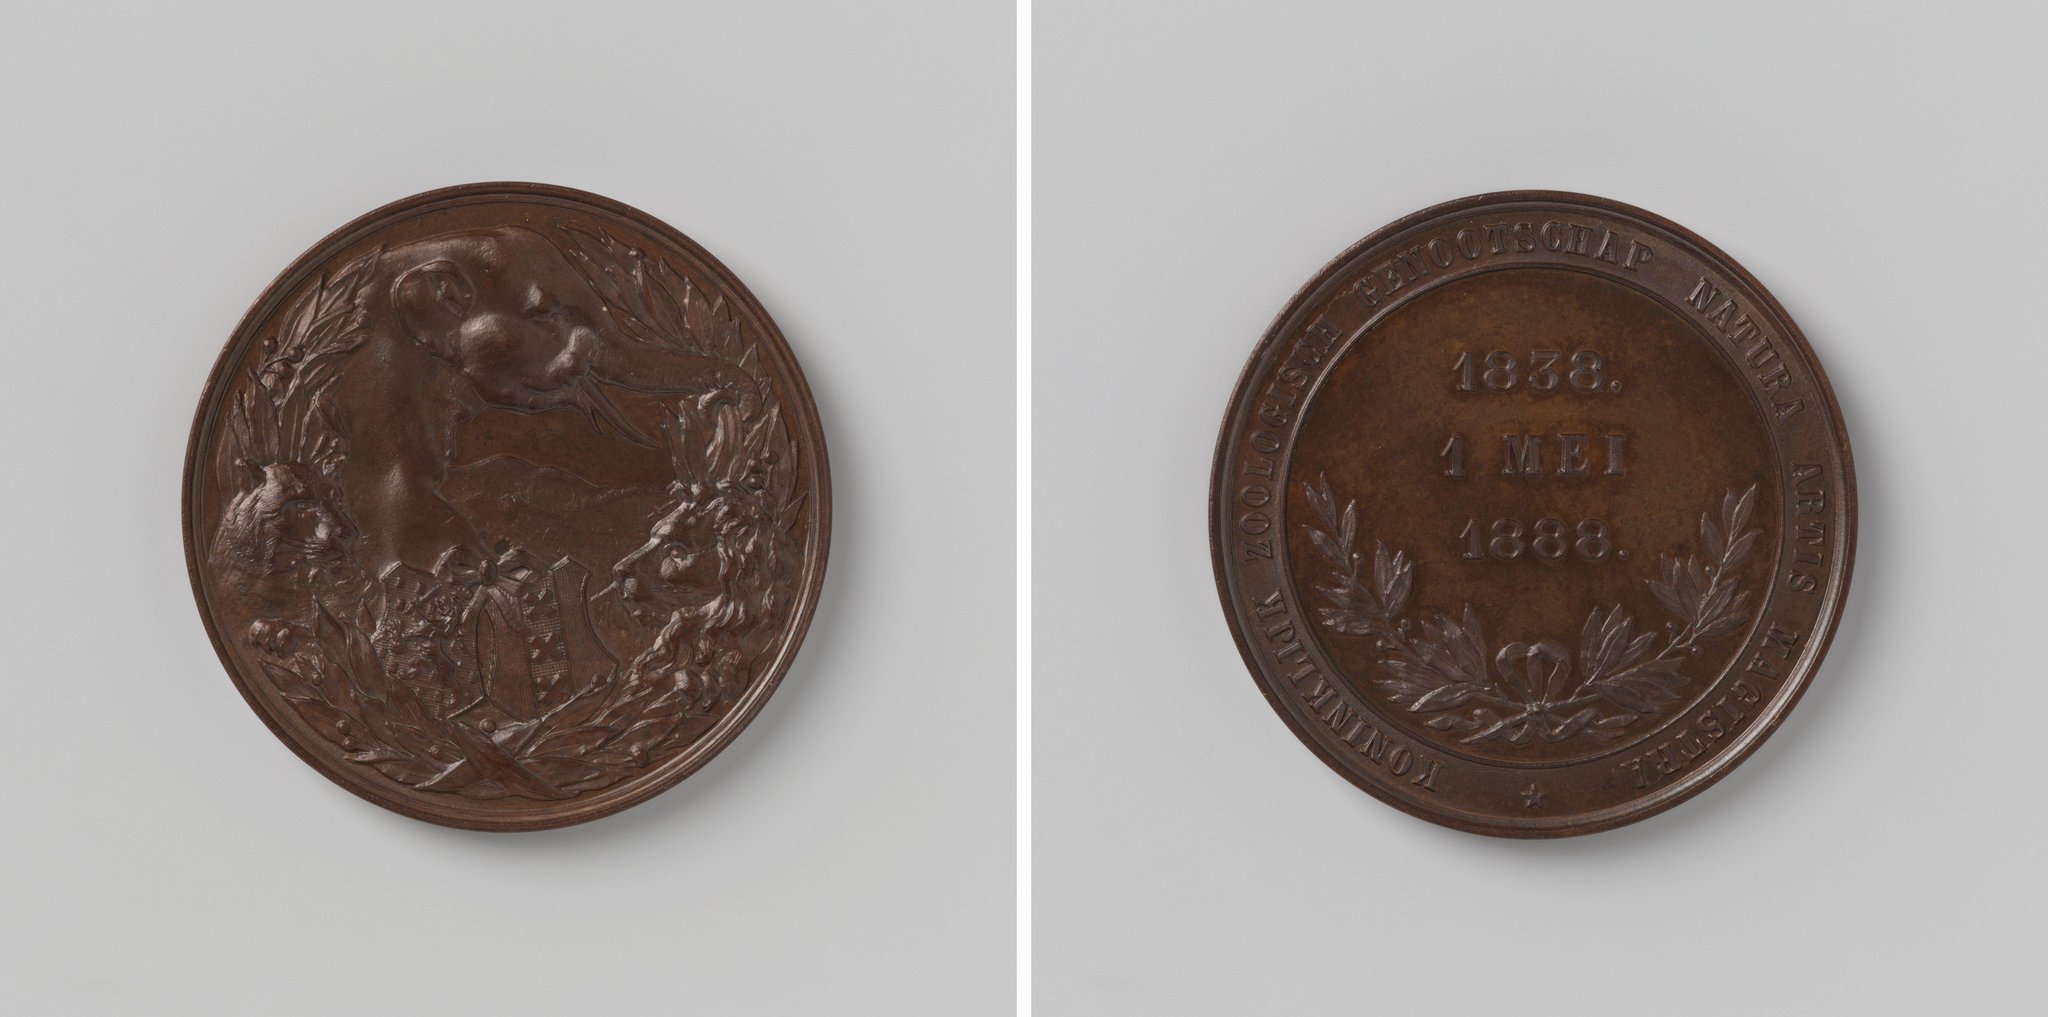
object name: history medal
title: Vijftigjarig bestaan van het Koninklijk Zoologisch genootschap "Natura Artis Magistra"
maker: Anonymous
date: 1888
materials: bronze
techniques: striking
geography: netherlands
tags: amsterdam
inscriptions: date: ‘1838 1 MEI 1888’, circumscription: ‘KONINKLIJK ZOOLOGISCH GENOOTSCHAP NATURA ARTIS MAGISTRA’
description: Bronzen penning. Voorzijde: twee met lint samengebonden wapenschilden voor heuvellandschap, omringd door leeuw, tijger en olifant binnen lauwerkrans. Keerzijde: opschrift boven twee samengebonden lauwertakken binnen omschrift.